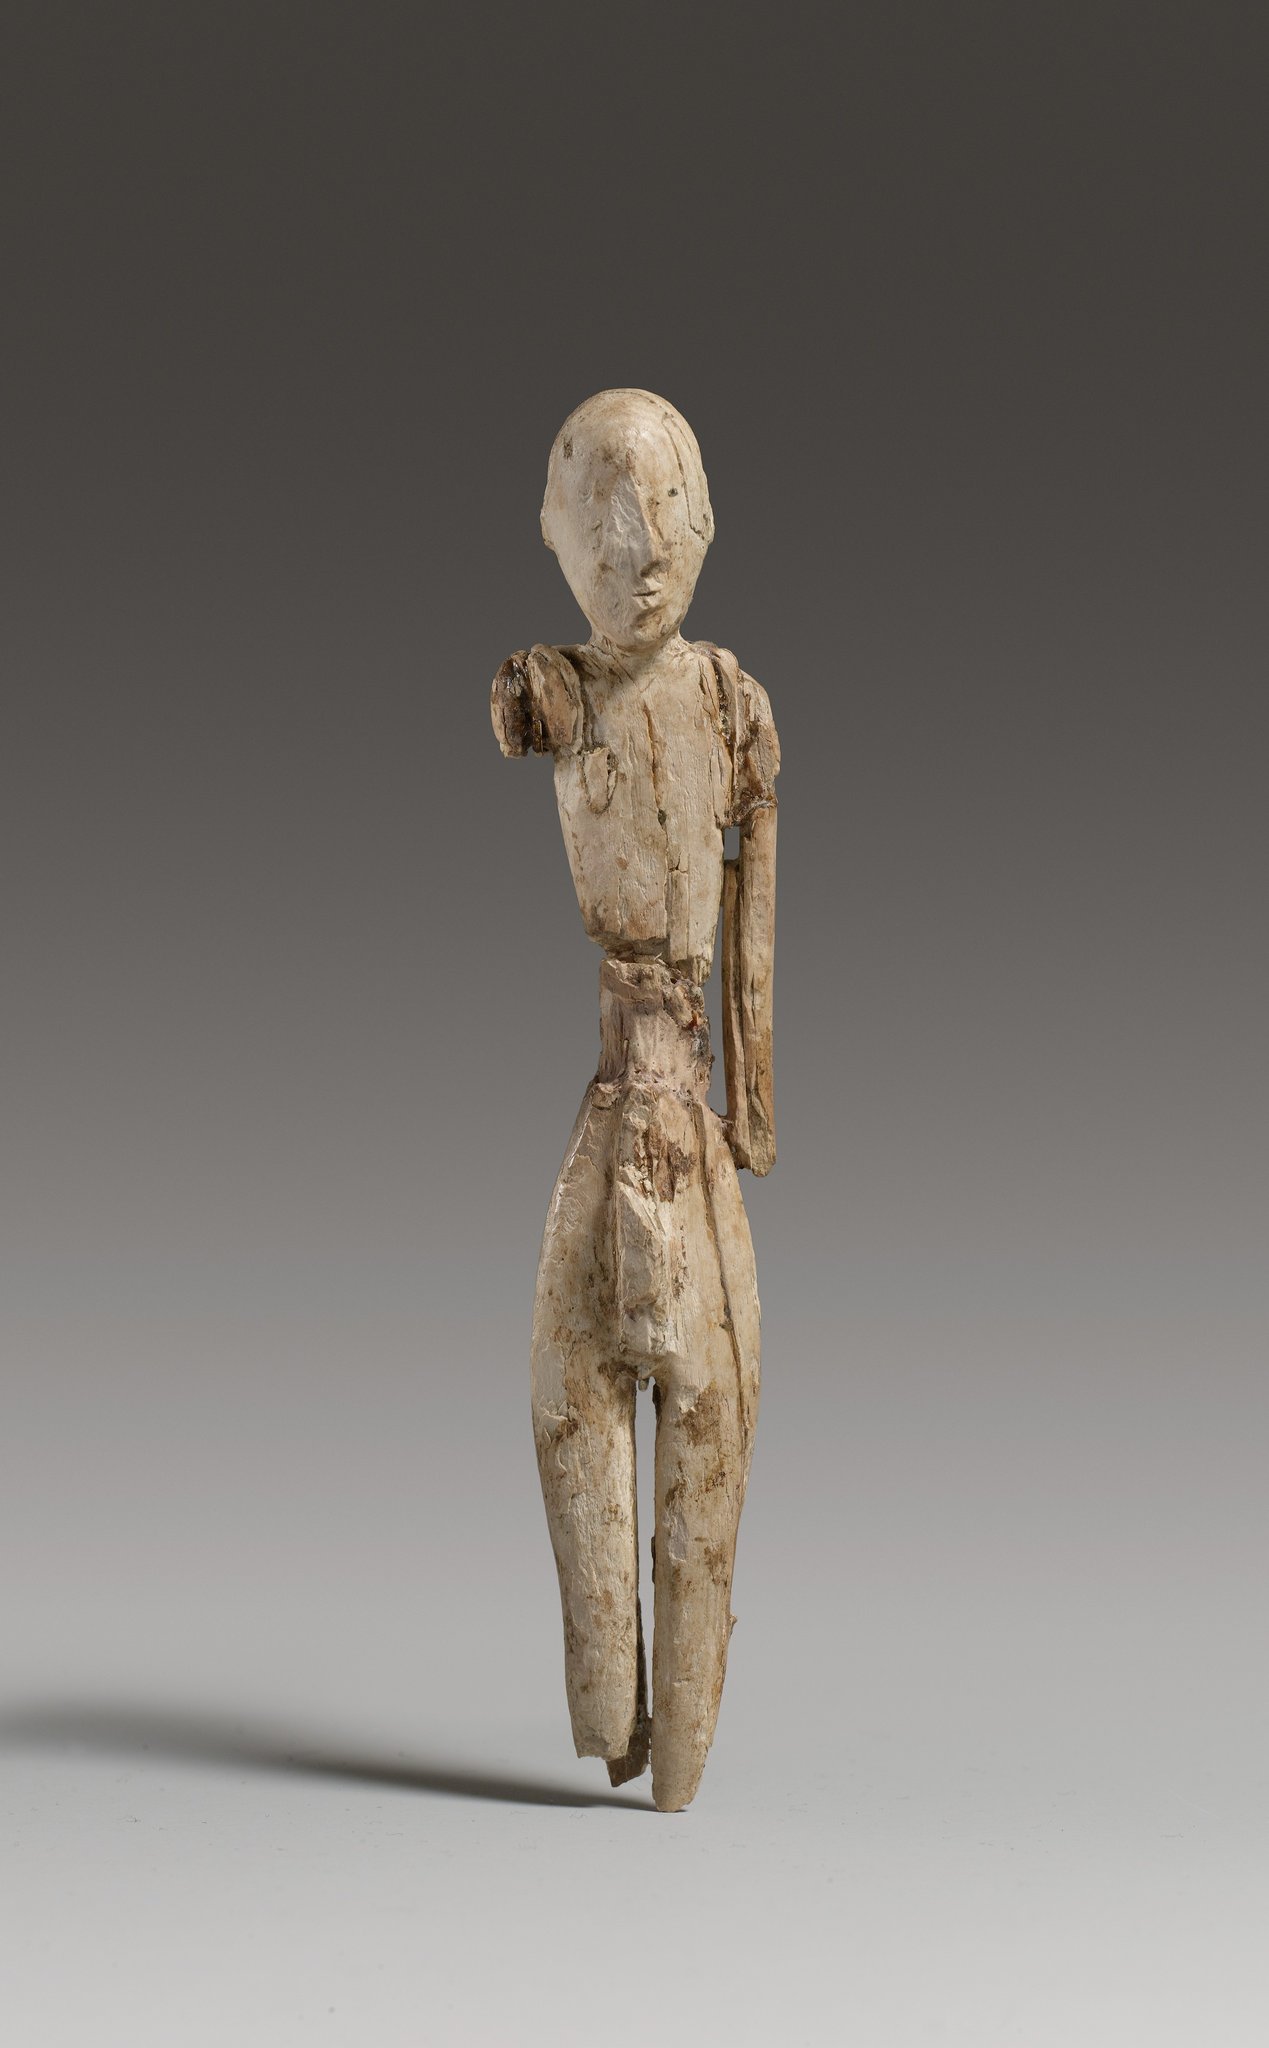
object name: statuette, male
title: Male figure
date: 3300-3100 BCE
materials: ivory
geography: egypt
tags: men